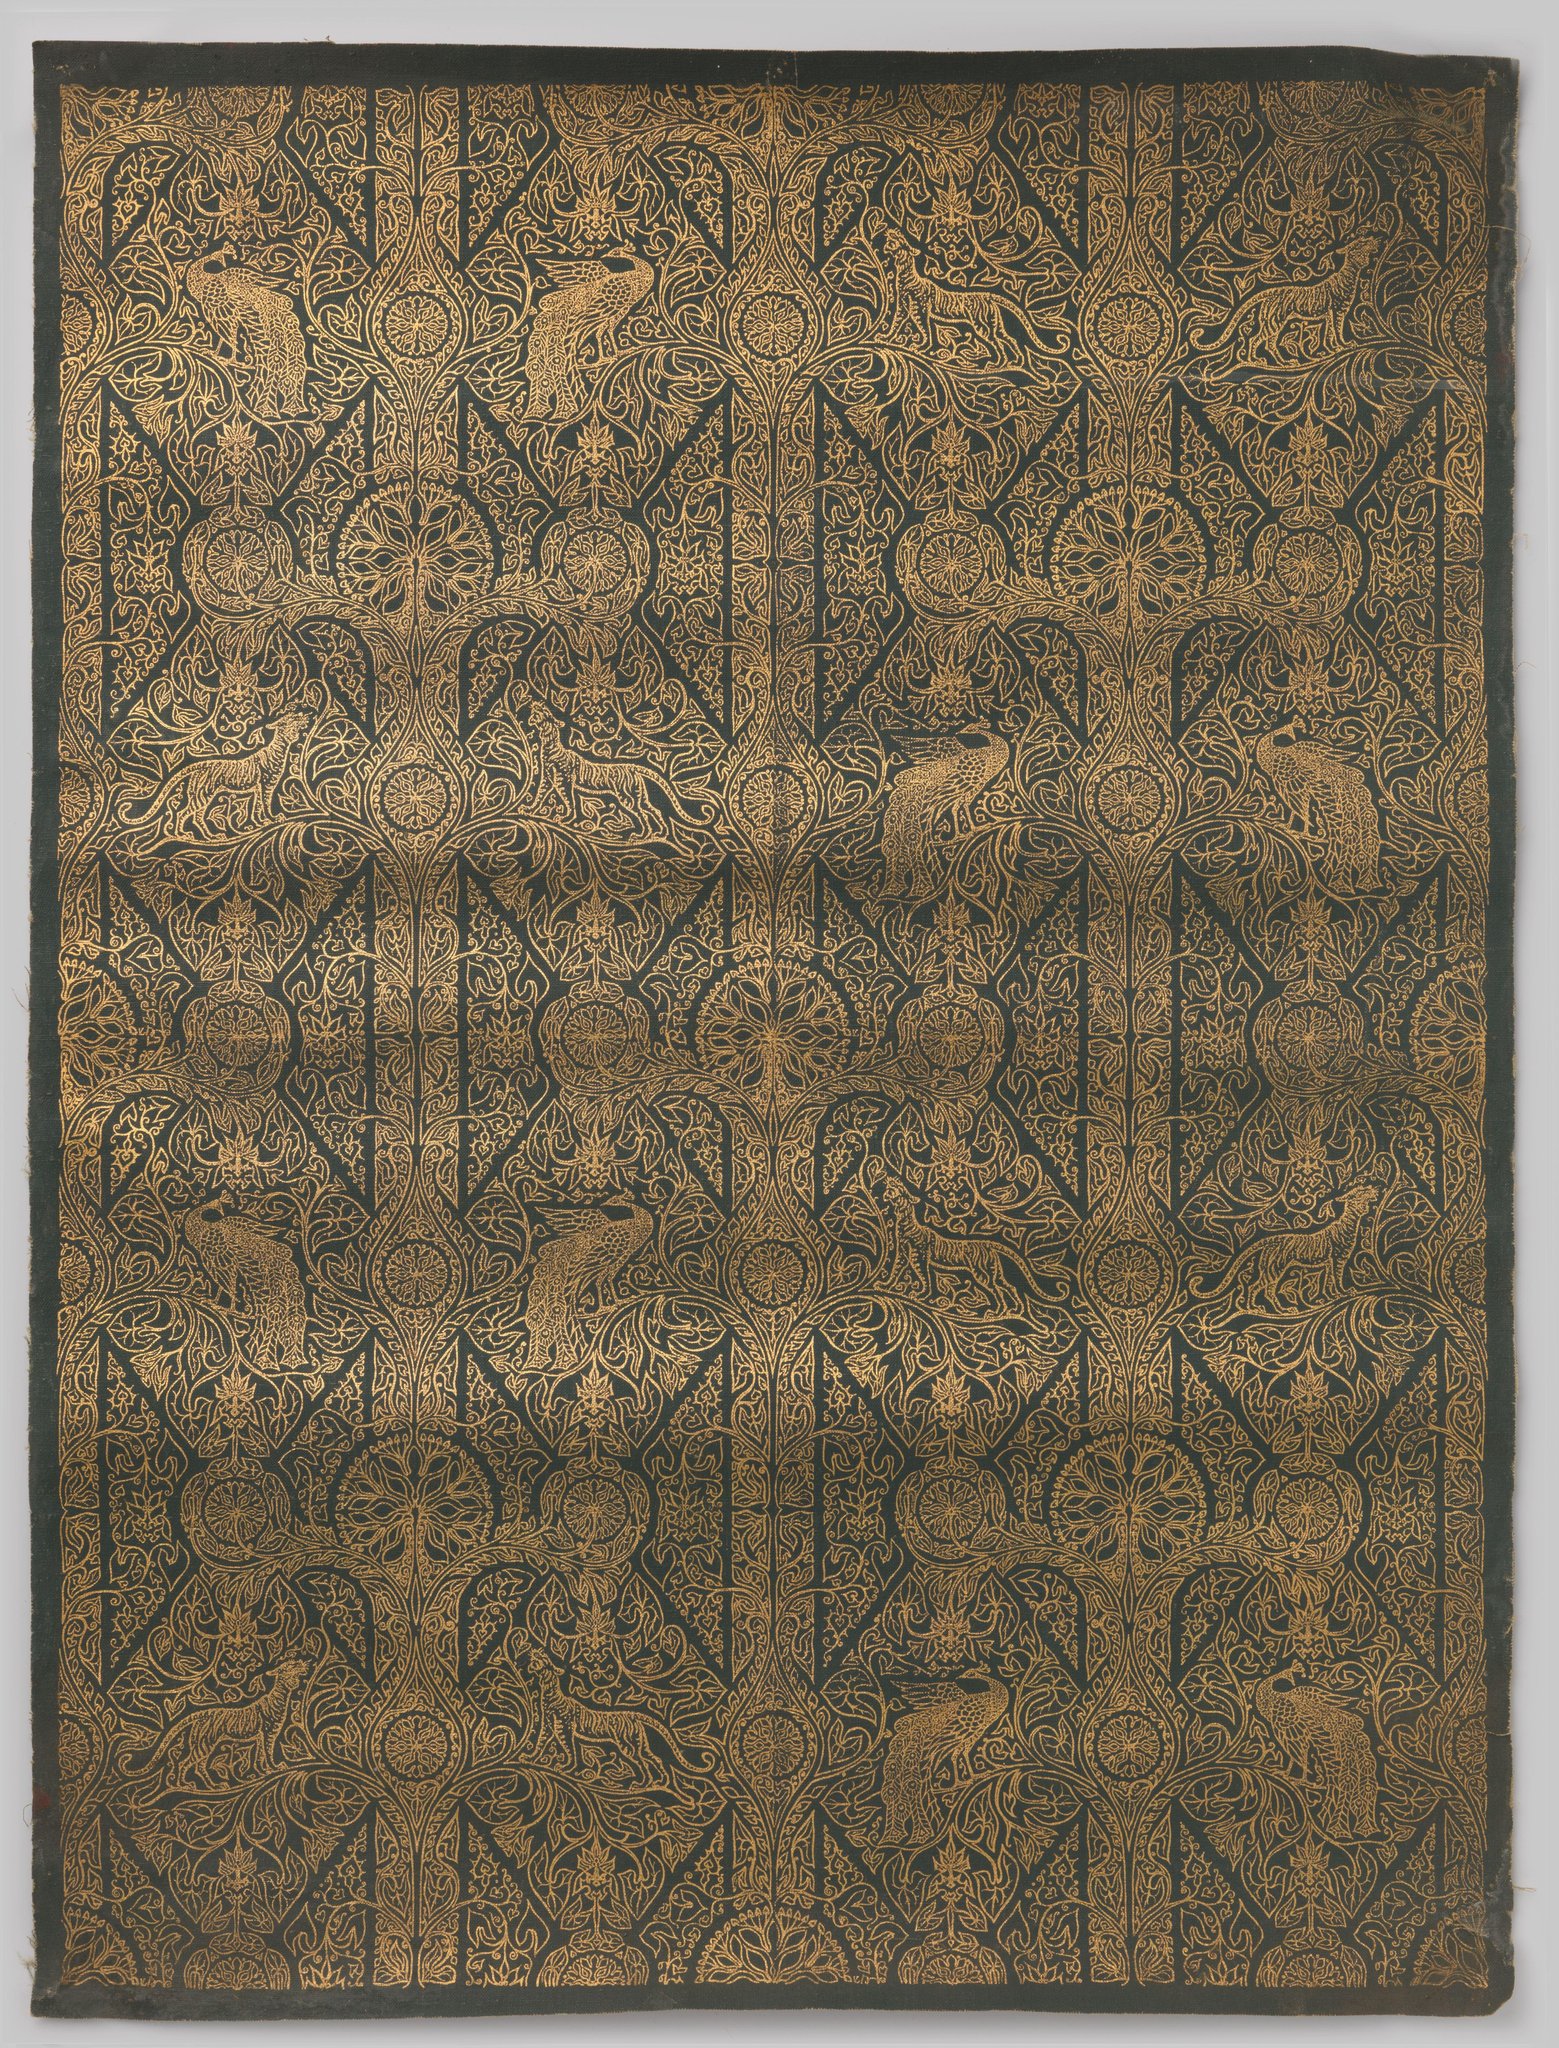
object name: upholstered wall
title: Wandbespanning van linnen met opdruk in goud op grijs fond met gestileerd rankenpatroon binnen ruiten waarin afwisselend een tijger of een pauw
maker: Anonymous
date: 1890-1910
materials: linen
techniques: painted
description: Wandbespanning, een vel, van linnen met opdruk in goud op grijs fond met gestileerd rankenpatroon binnen ruiten waarin afwisselend een tijger of een pauw.